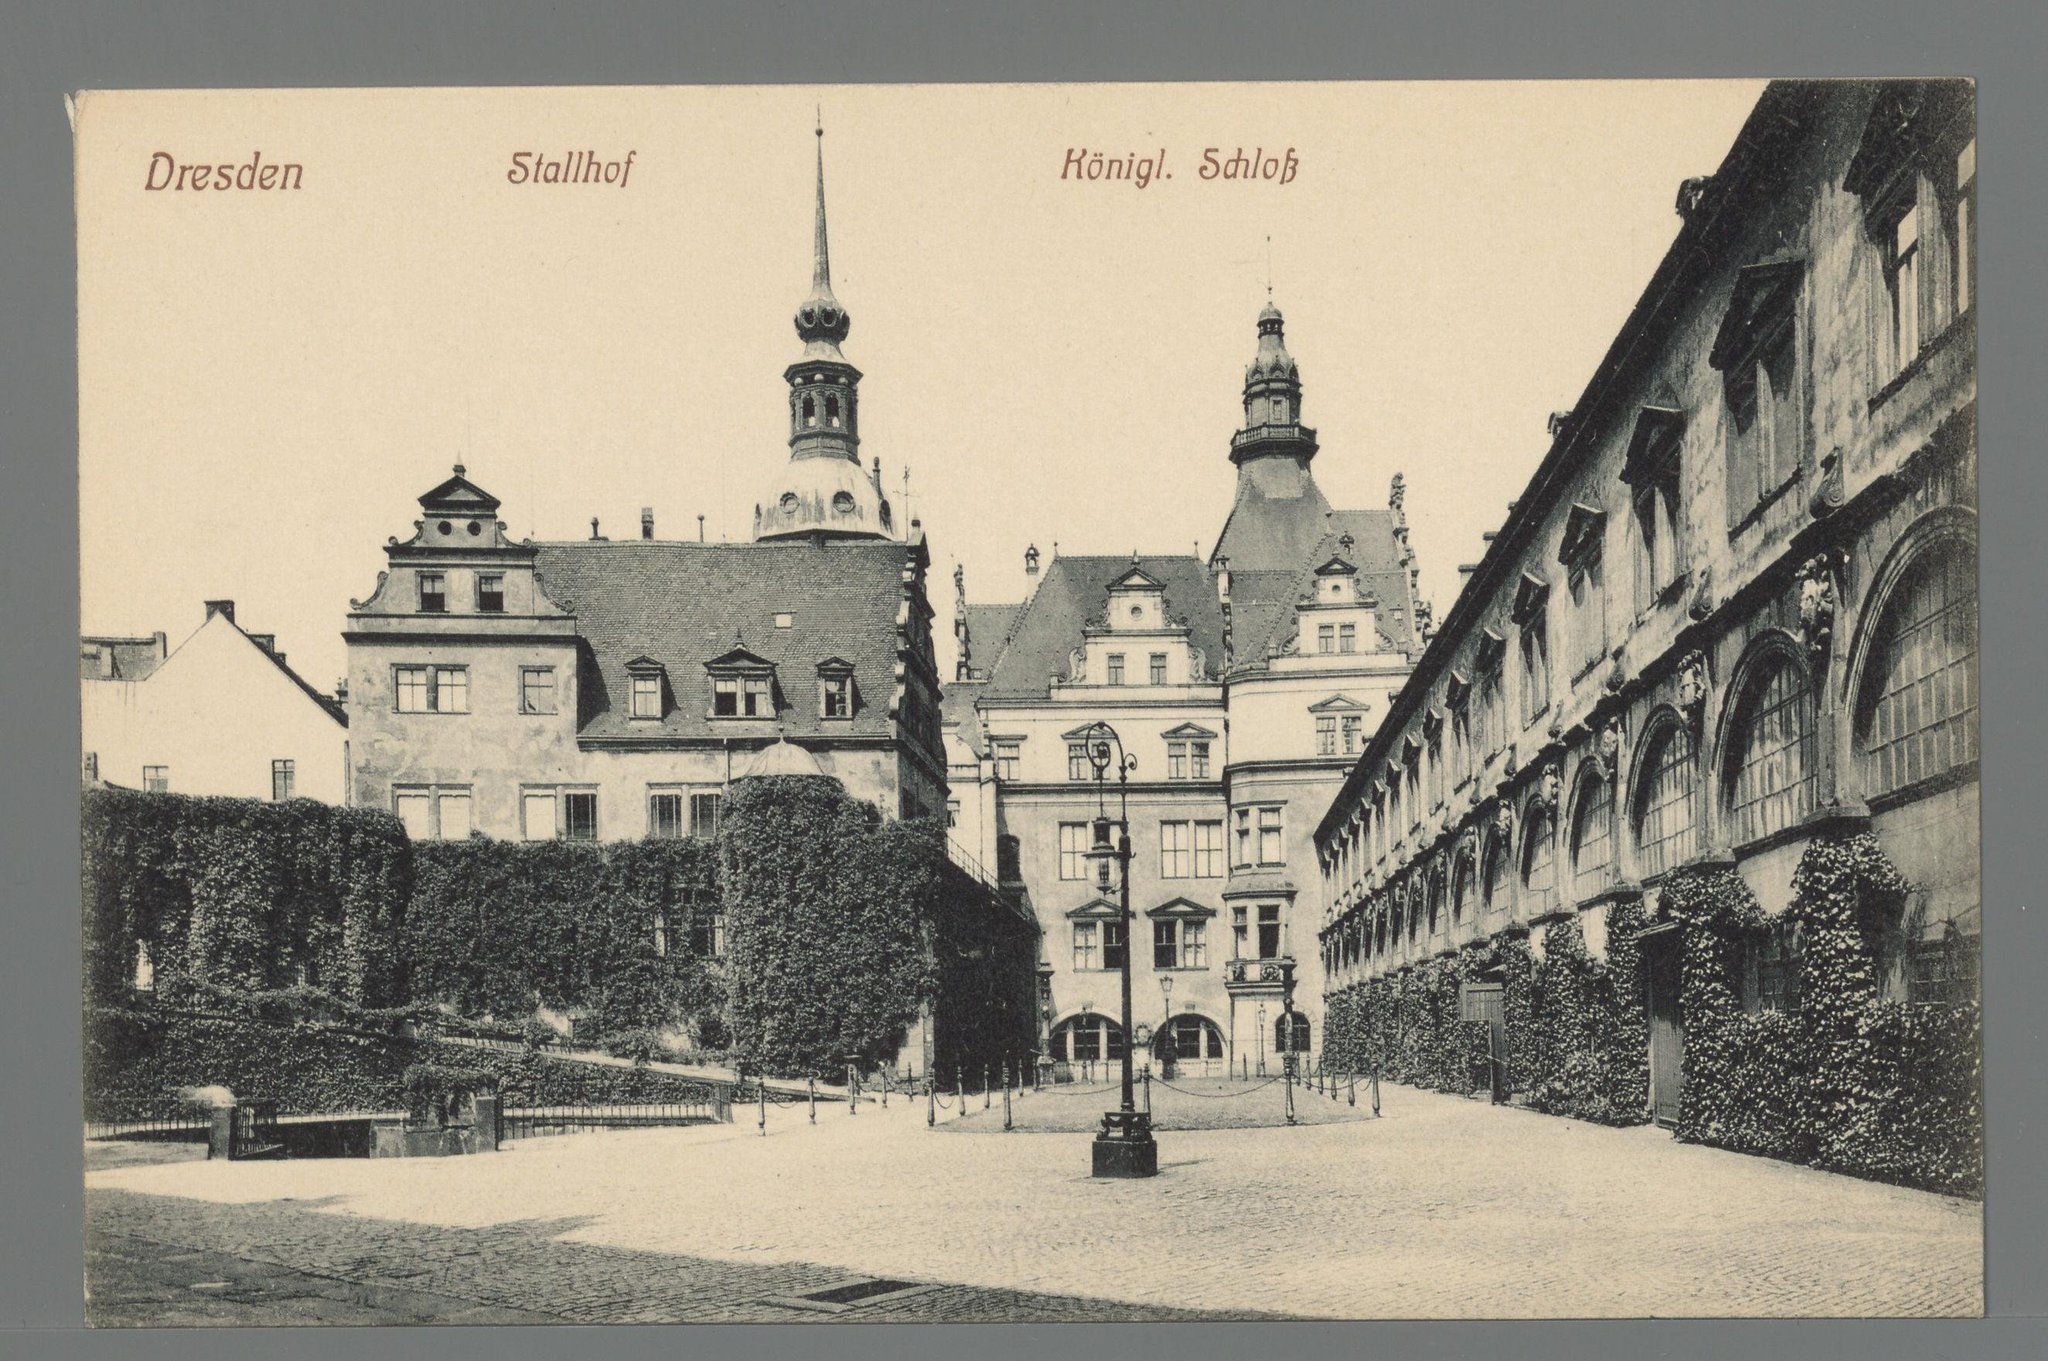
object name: ansichtkaart, prentbriefkaart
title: Dresden. Stallhof. Konigl. Schloβ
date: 1905-1930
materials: cardboard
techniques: photograph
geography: dresden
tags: castle